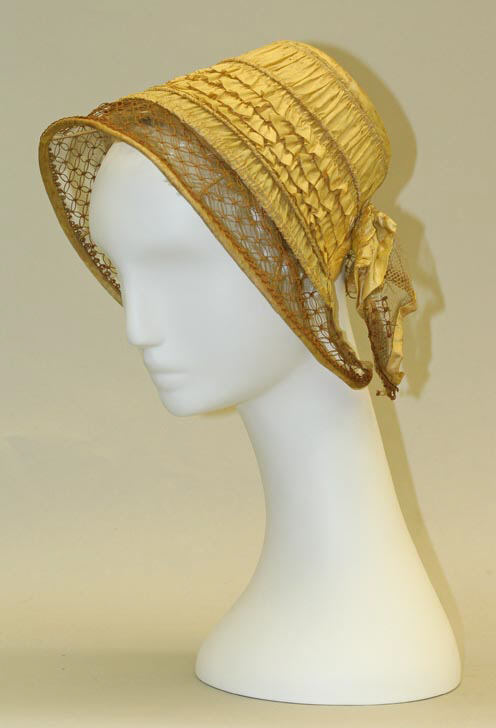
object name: bonnet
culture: american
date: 1840-1850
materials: silk, fiber